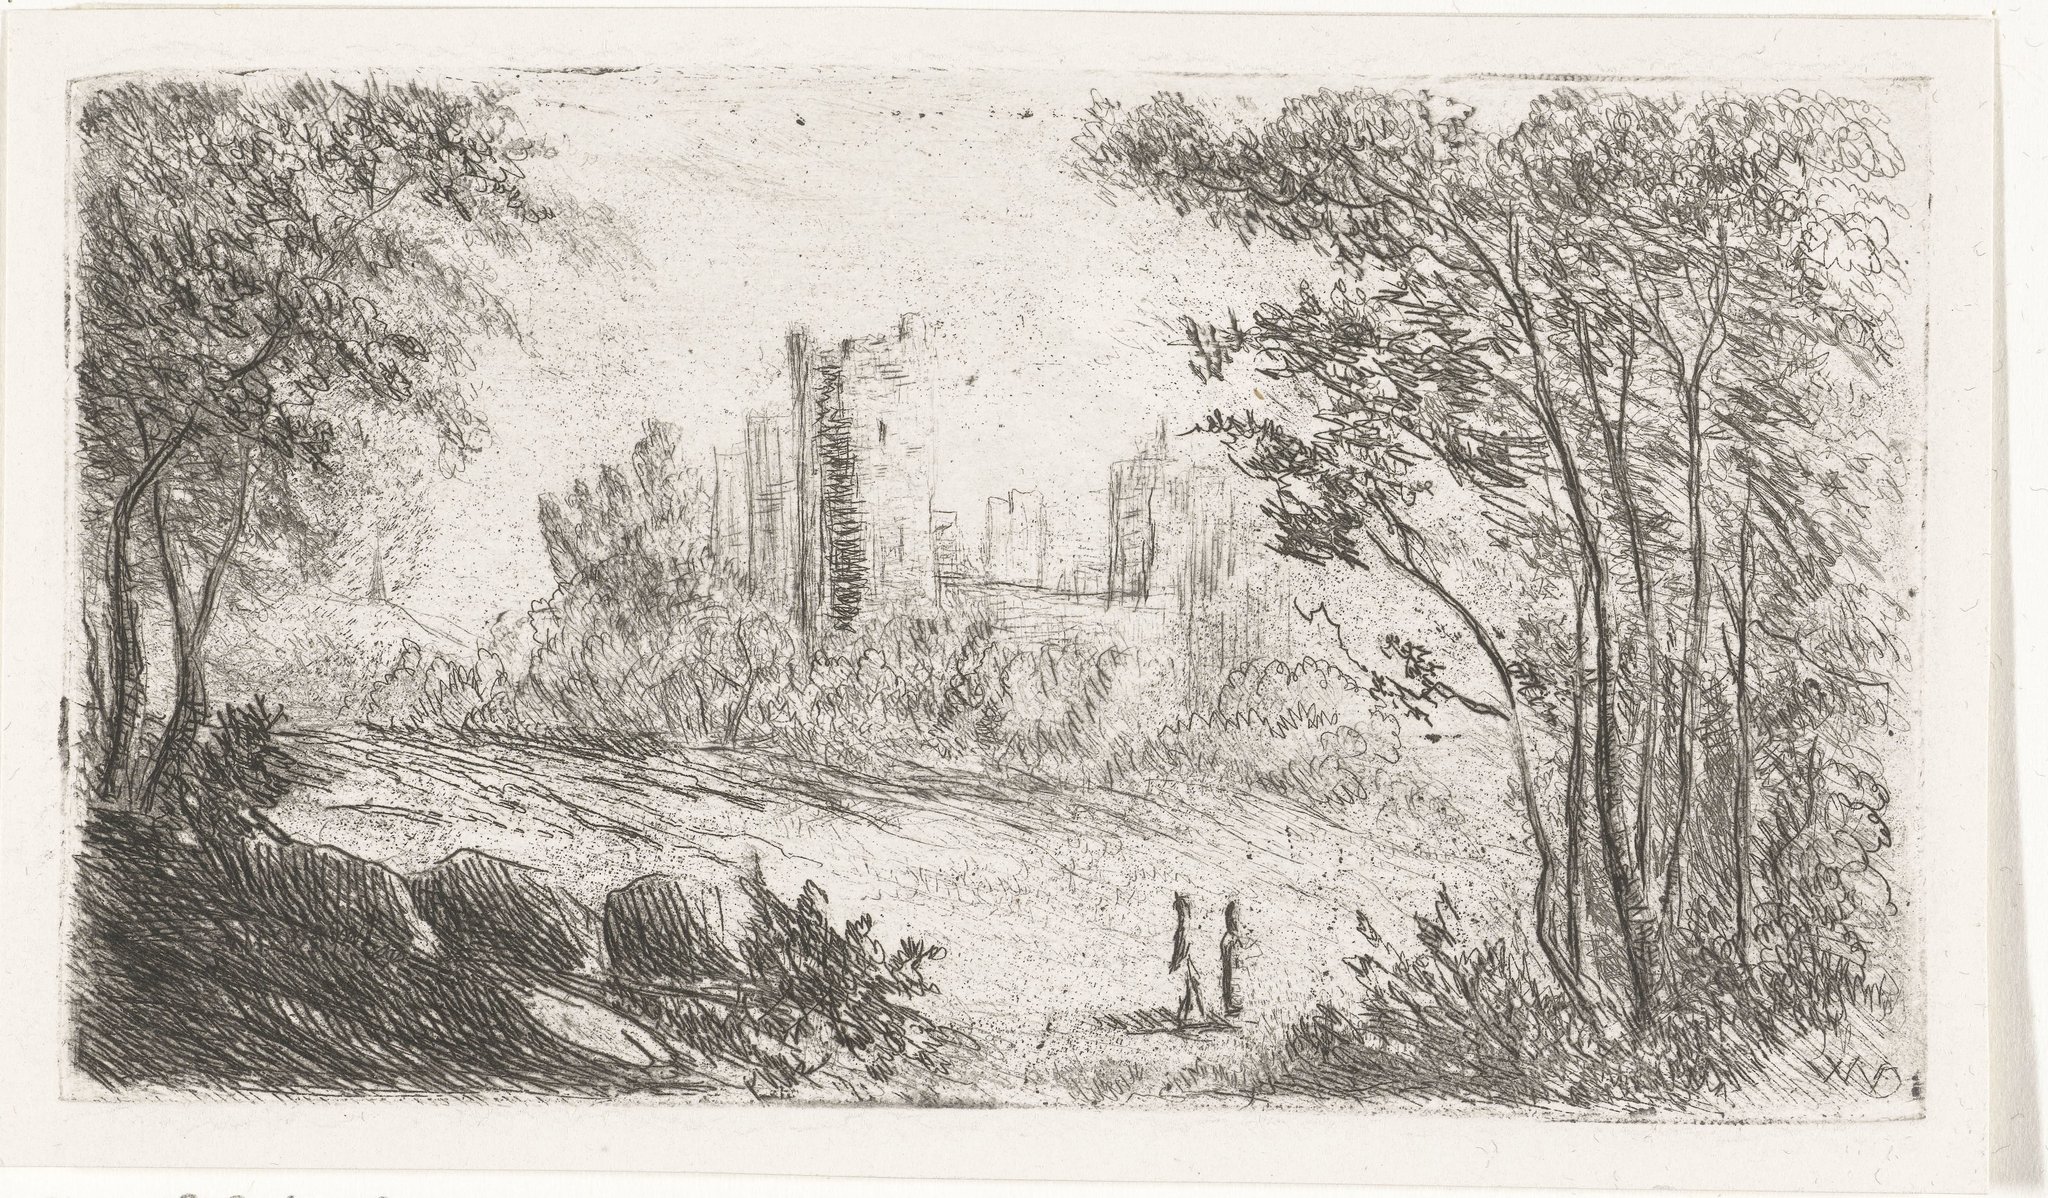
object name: print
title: Landschap met ruïne van kasteel en twee figuren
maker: willem matthias jan van dielen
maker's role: print maker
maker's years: 1805-1867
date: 1815-1867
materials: paper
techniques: etching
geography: netherlands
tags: landscape with ruins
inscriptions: collector's mark: Lugt 2228